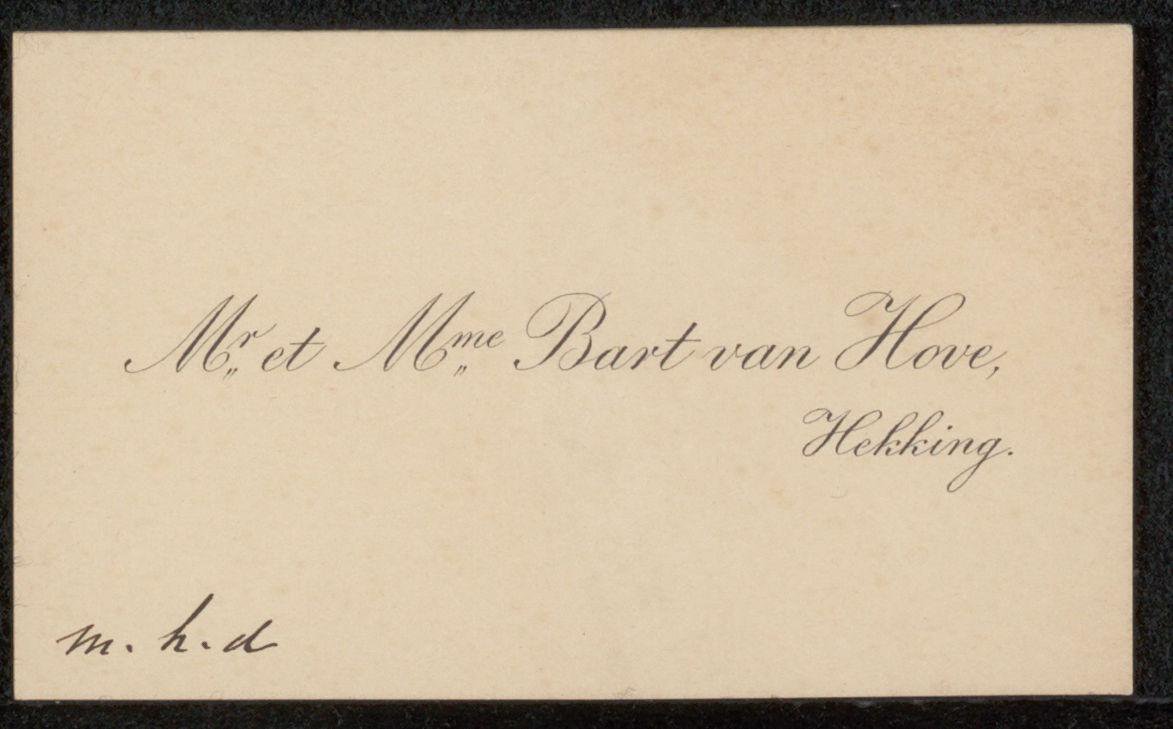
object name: visiting card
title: Visitekaartje aan Philip Zilcken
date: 1900-1914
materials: cardboard, ink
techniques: pen, printing, writing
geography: amsterdam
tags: painter, draughtsman, philip zilcken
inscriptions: collector's mark: ‘RPK’